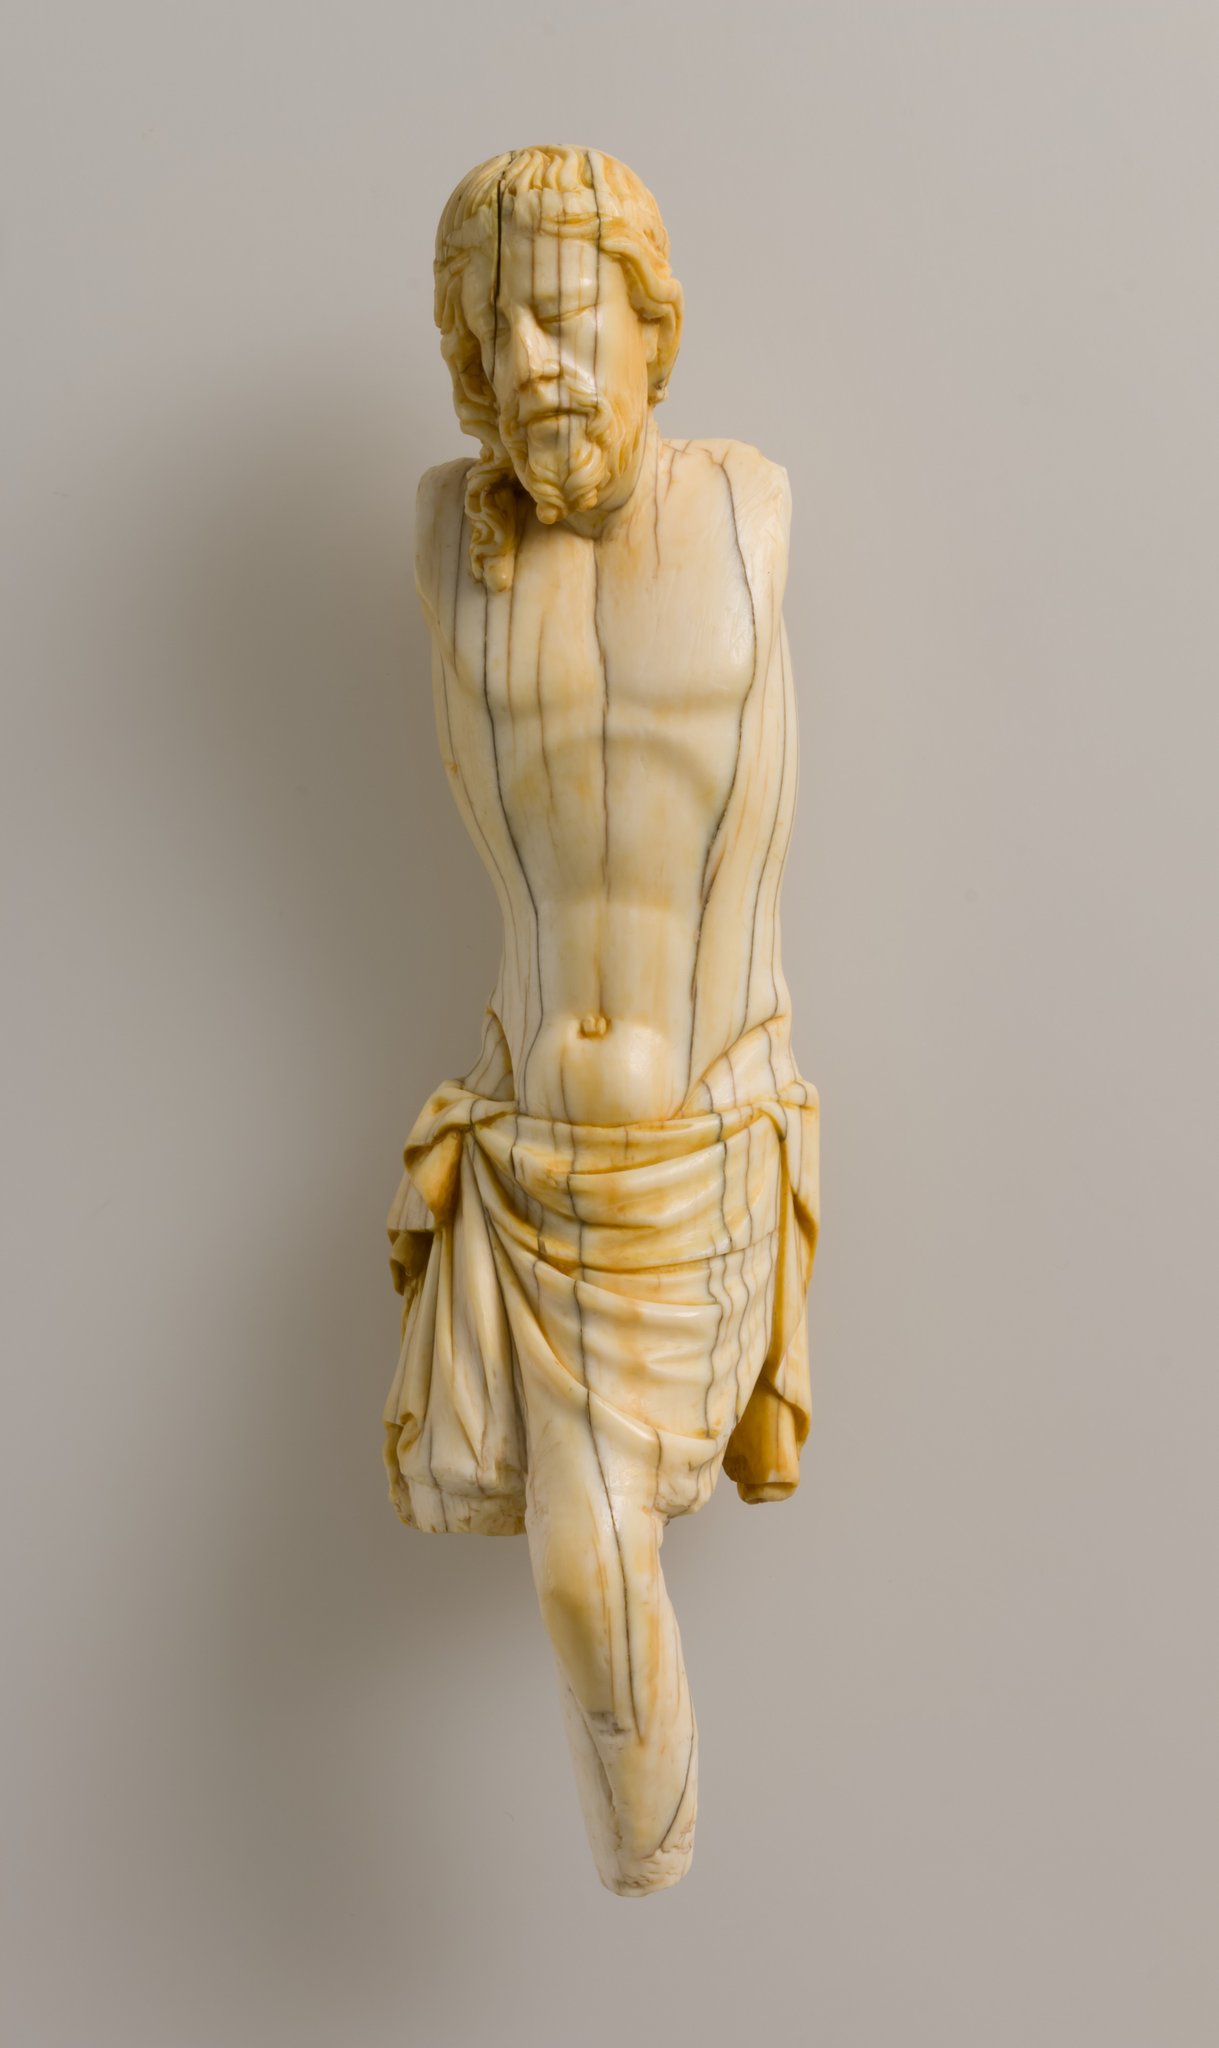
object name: statuette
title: Crucified Christ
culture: french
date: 1260-1280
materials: ivory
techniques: polychromy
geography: france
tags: christ